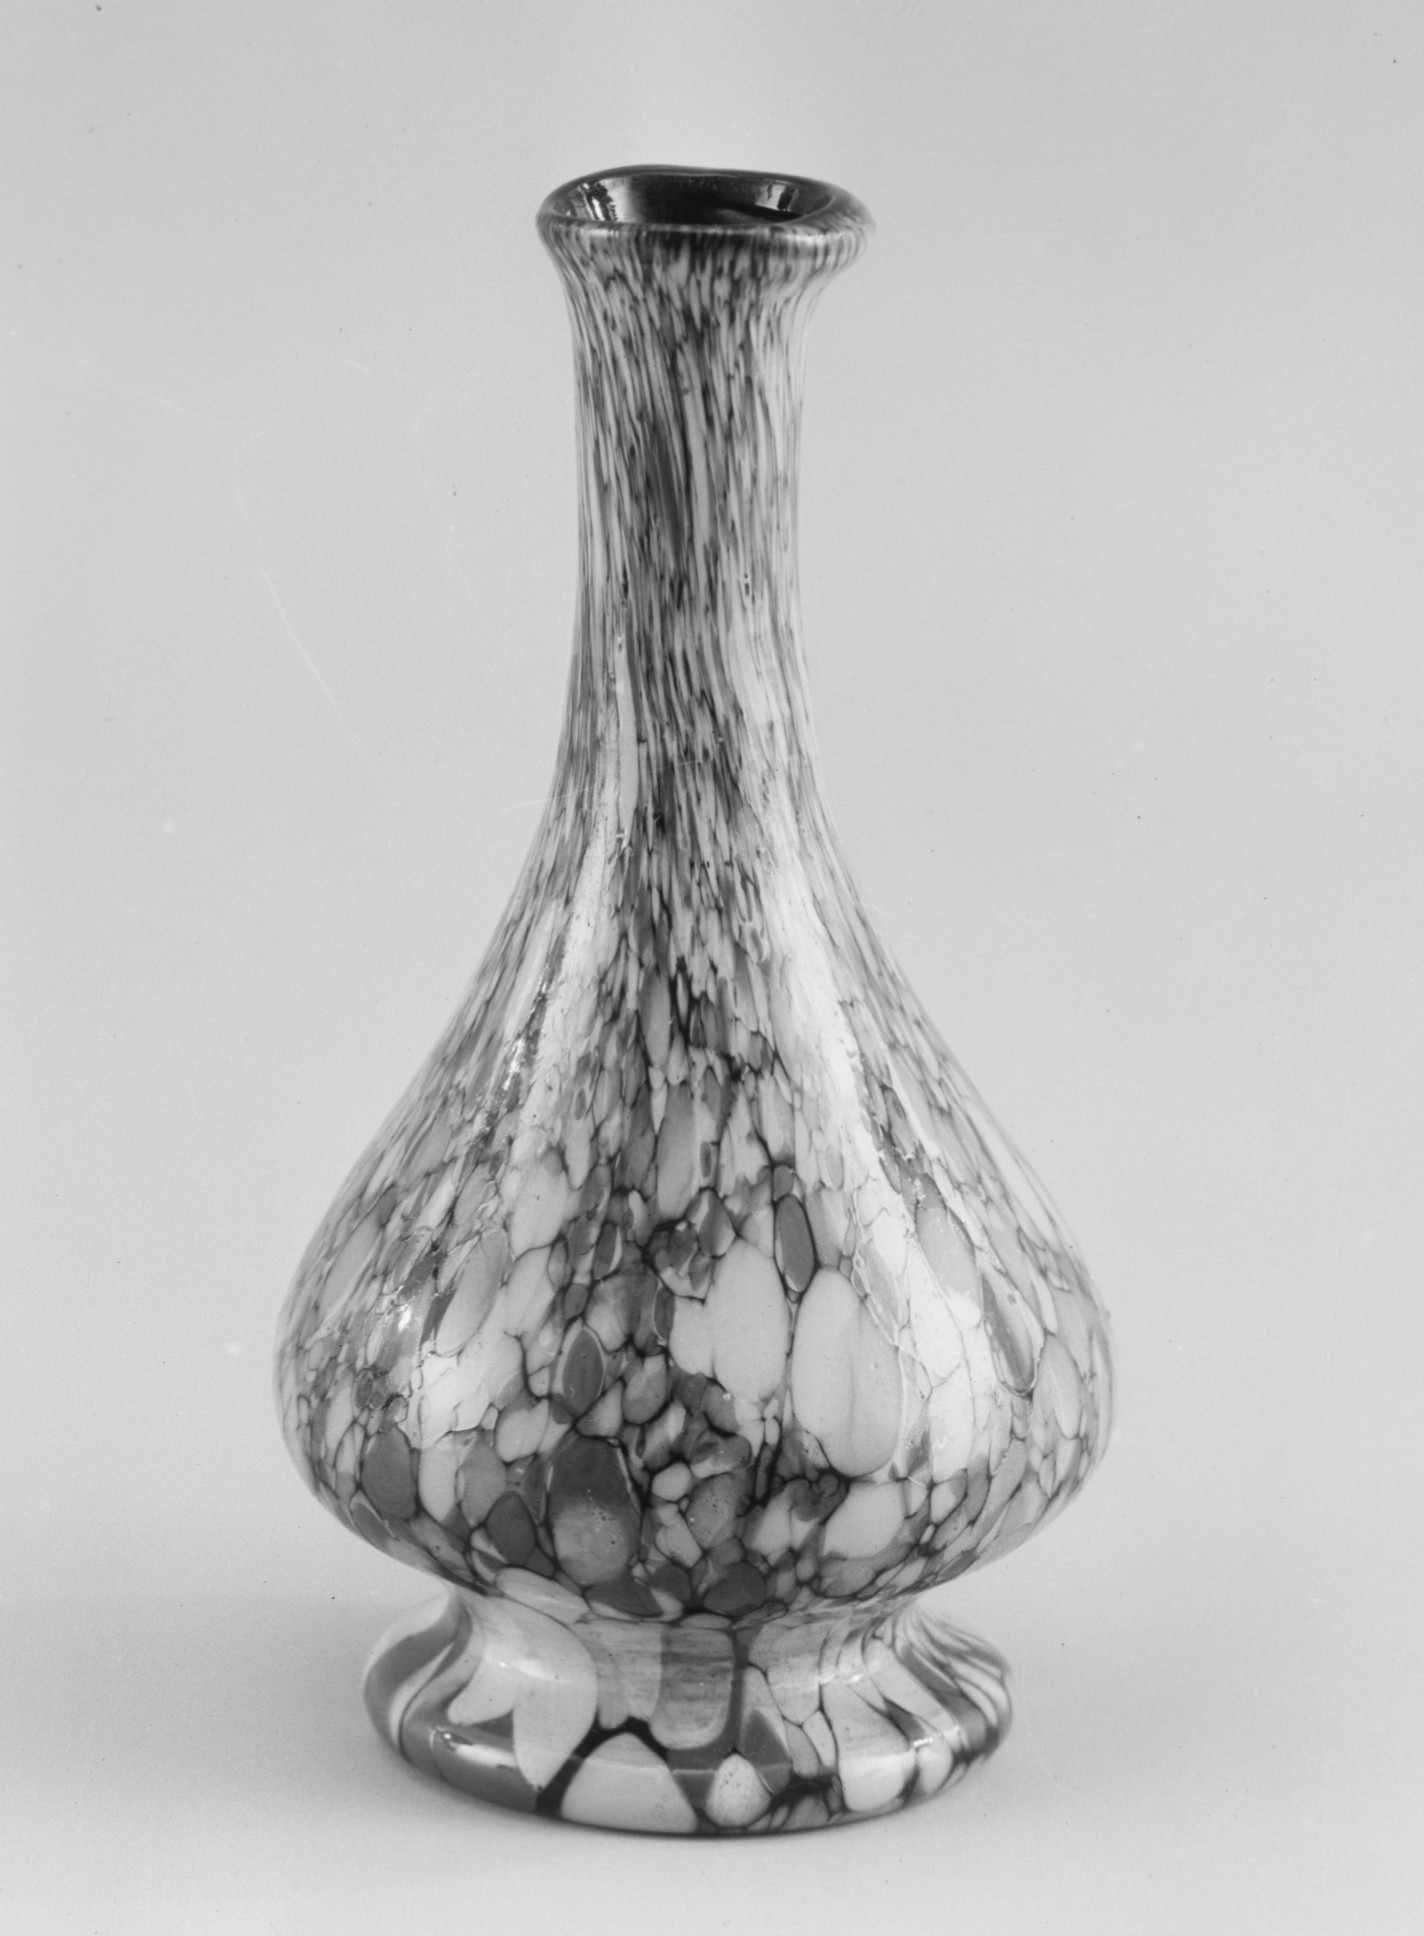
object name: vase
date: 1601-1800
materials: glass